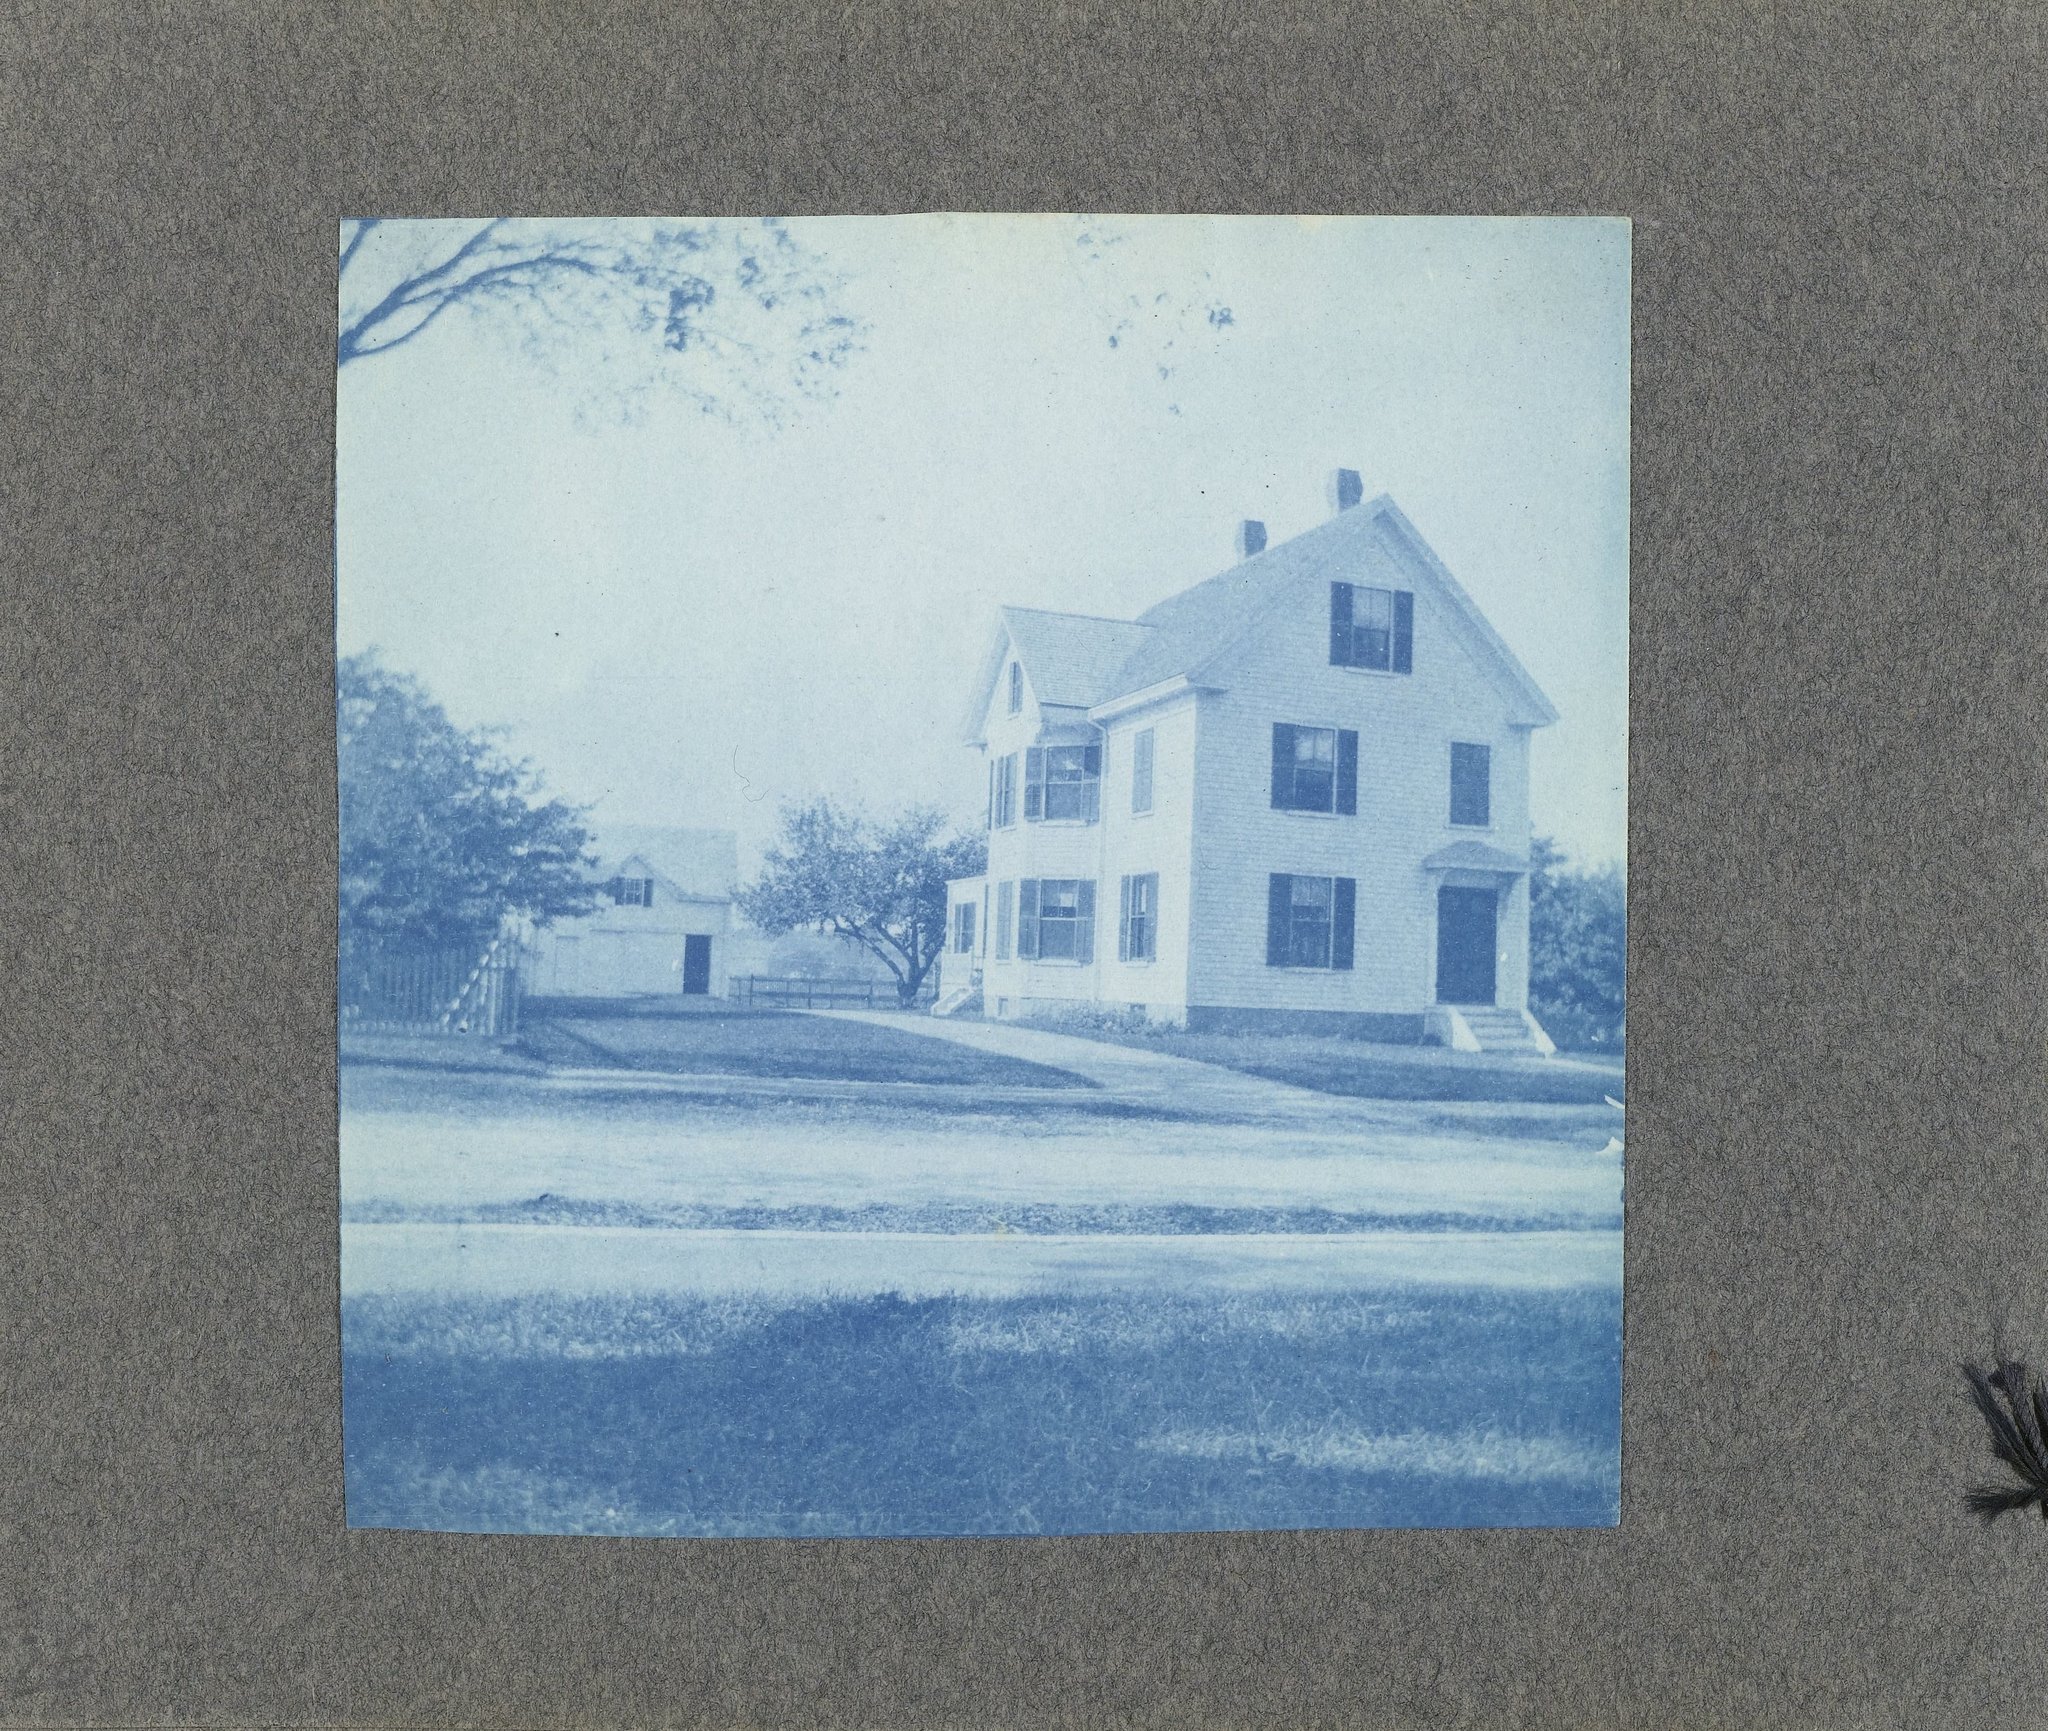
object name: photograph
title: Houten huis met gazon, Verenigde Staten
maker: Anonymous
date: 1900-1920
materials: paper, photographic support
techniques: cyanotype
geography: united states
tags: country-house, united states of america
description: Onderdeel van Fotoalbum met 53 cyanotypieën van kinderen, paarden, huizen, boten en strandtaferelen in de Verenigde Staten.